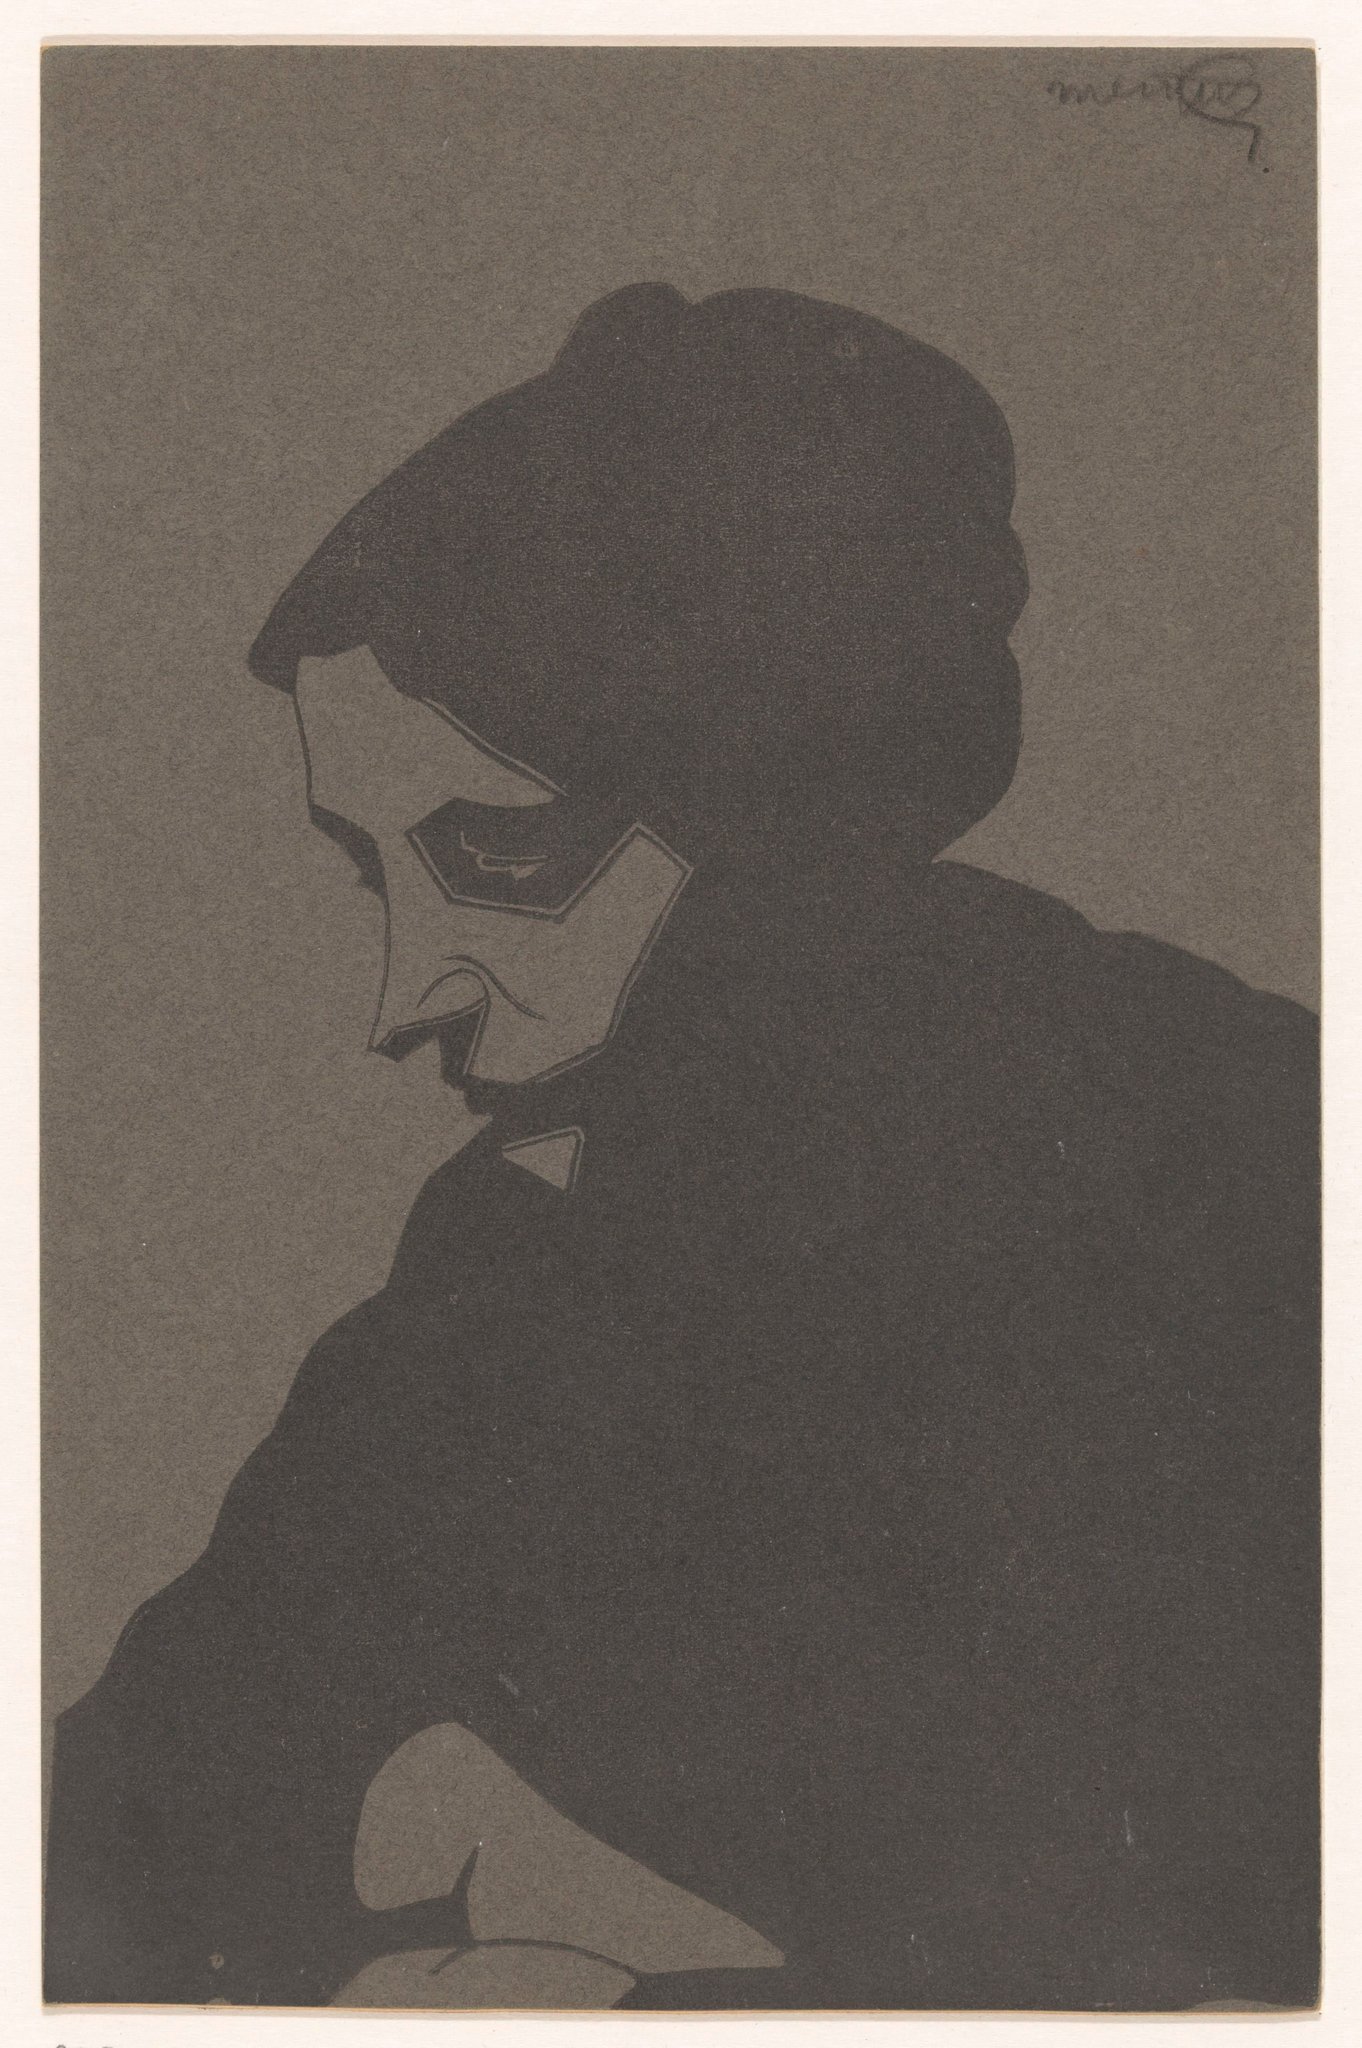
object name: print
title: Portret van een onbekende vrouw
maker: samuel jessurun de mesquita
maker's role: draughtsman, print maker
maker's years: 1868-1944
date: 1913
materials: paper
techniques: woodcut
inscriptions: signature:, collector's mark: Lugt 2228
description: Naar beneden kijkende vrouw in driekwart aanzicht naar links, met slagschaduw.